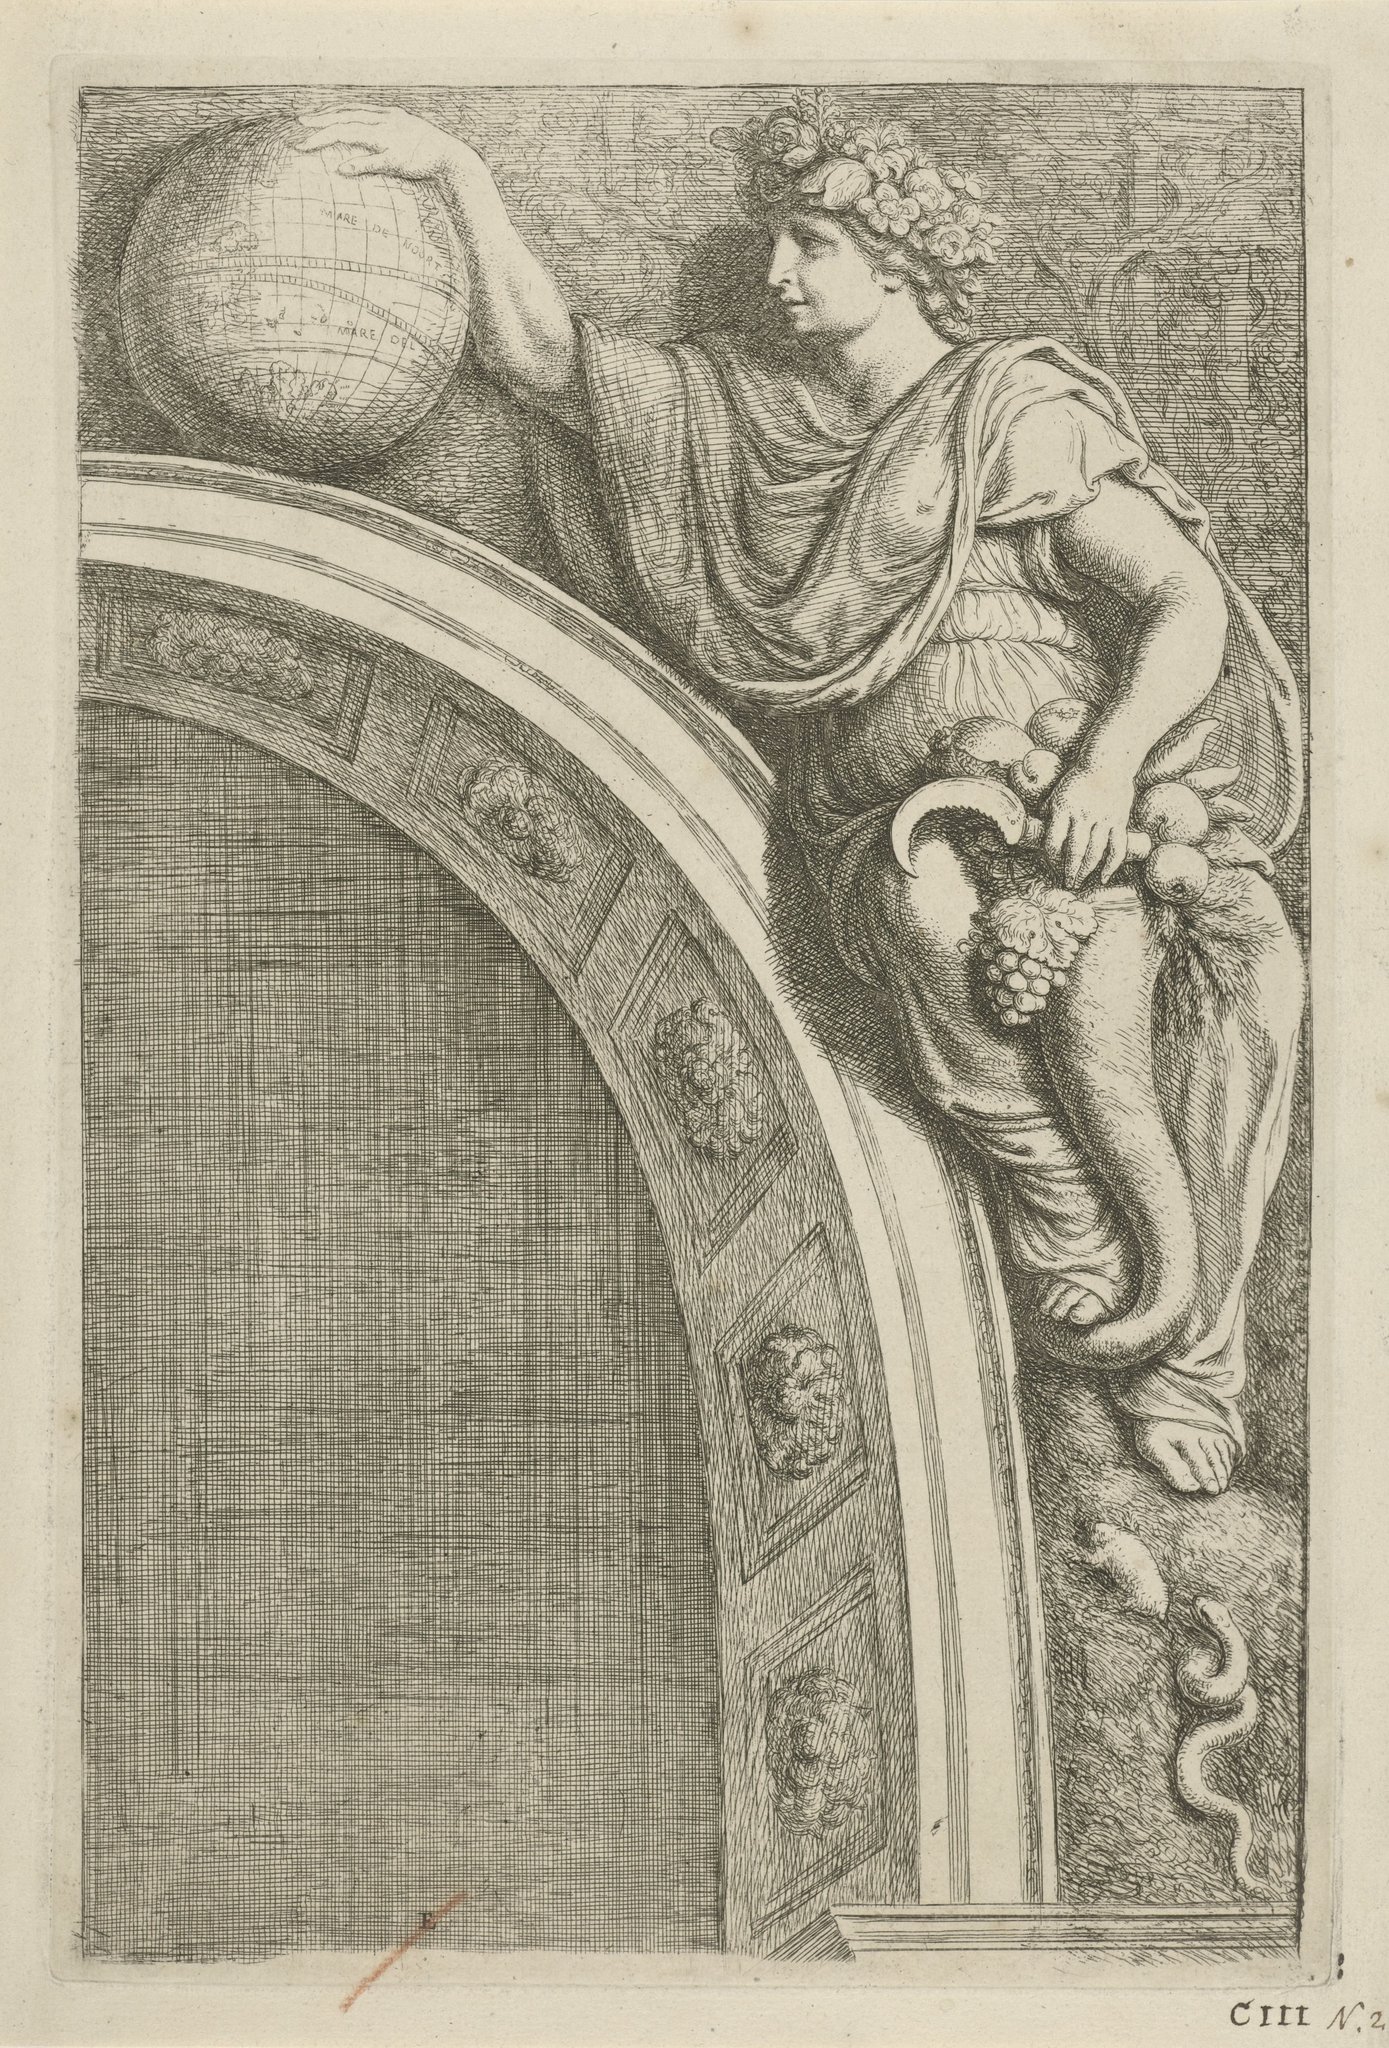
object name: book illustration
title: Reliëf met personificatie van het element Aarde boven boog aan westzijde van de Burgerzaal in het Stadhuis op de Dam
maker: hubert quellinus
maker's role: print maker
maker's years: 1619-1687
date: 1663-1668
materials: chalk, ink, paper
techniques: engraving, etching, pen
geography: amsterdam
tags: snakes, 'cornucopia', horn of plenty, earth (one of the four elements), other mammals: mole, globe, agricultural implements: sickle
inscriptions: inscription: ‘CIII N. 2’, collector's mark: Lugt 2228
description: Huidige staat van prent ook gebruikt in: Secunca pars Praecipuarum effigierum ac ornamentorum amplissime Curiae Amstelrodamensis maiori ex parte in cadido marmore effectorum per Artum Quellinium eiusdem Civitatis Statuarium / Het tweede deel Van de voornaemste Statuen ende Cieraten van 't konst-rijcke Stadt-huys van Amstelredam 'tmeeste in Marmer gemaeckt door Artus Quellinus Beelthouwer der voorseyde Stadt. Amsterdam: Artus Quellinus (I), 1663. En in: Secunca pars Praecipuarum effigierum ac ornamentorum amplissime Curiae Amstelrodamensis maiori ex parte in cadido marmore effectorum per Artum Quellinium eiusdem Civitatis Statuarium / Het tweede deel Van de voornaemste Statuen ende Cieraten van 't konst-rijcke Stadt-huys van Amstelredam 'tmeeste in Marmer gemaeckt door Artus Quellinus Beelthouwer der voorseyde Stadt. Amsterdam: Frederik de Wit, 1668. Latere staat van prent ook gebruikt in: Architecture peinture et sculpture de la Maison de Ville d'Amsterdam, representee en CIX. figures en taille-douce (…). Amsterdam: David Mortier, 1719. En in: Architecture peinture et sculpture de la Maison de Ville d'Amsterdam, representee en CIX. figures en taille-douce (…). Amsterdam: Gerard Valck, 1719. En in: Bouw schilder en beeldhouwkonst, van het Stadhuis te Amsteldam, vertoont in CIX figuuren (…). Amsterdam: Covens & Mortier & Covens Jr., s.a. (1774-1783).